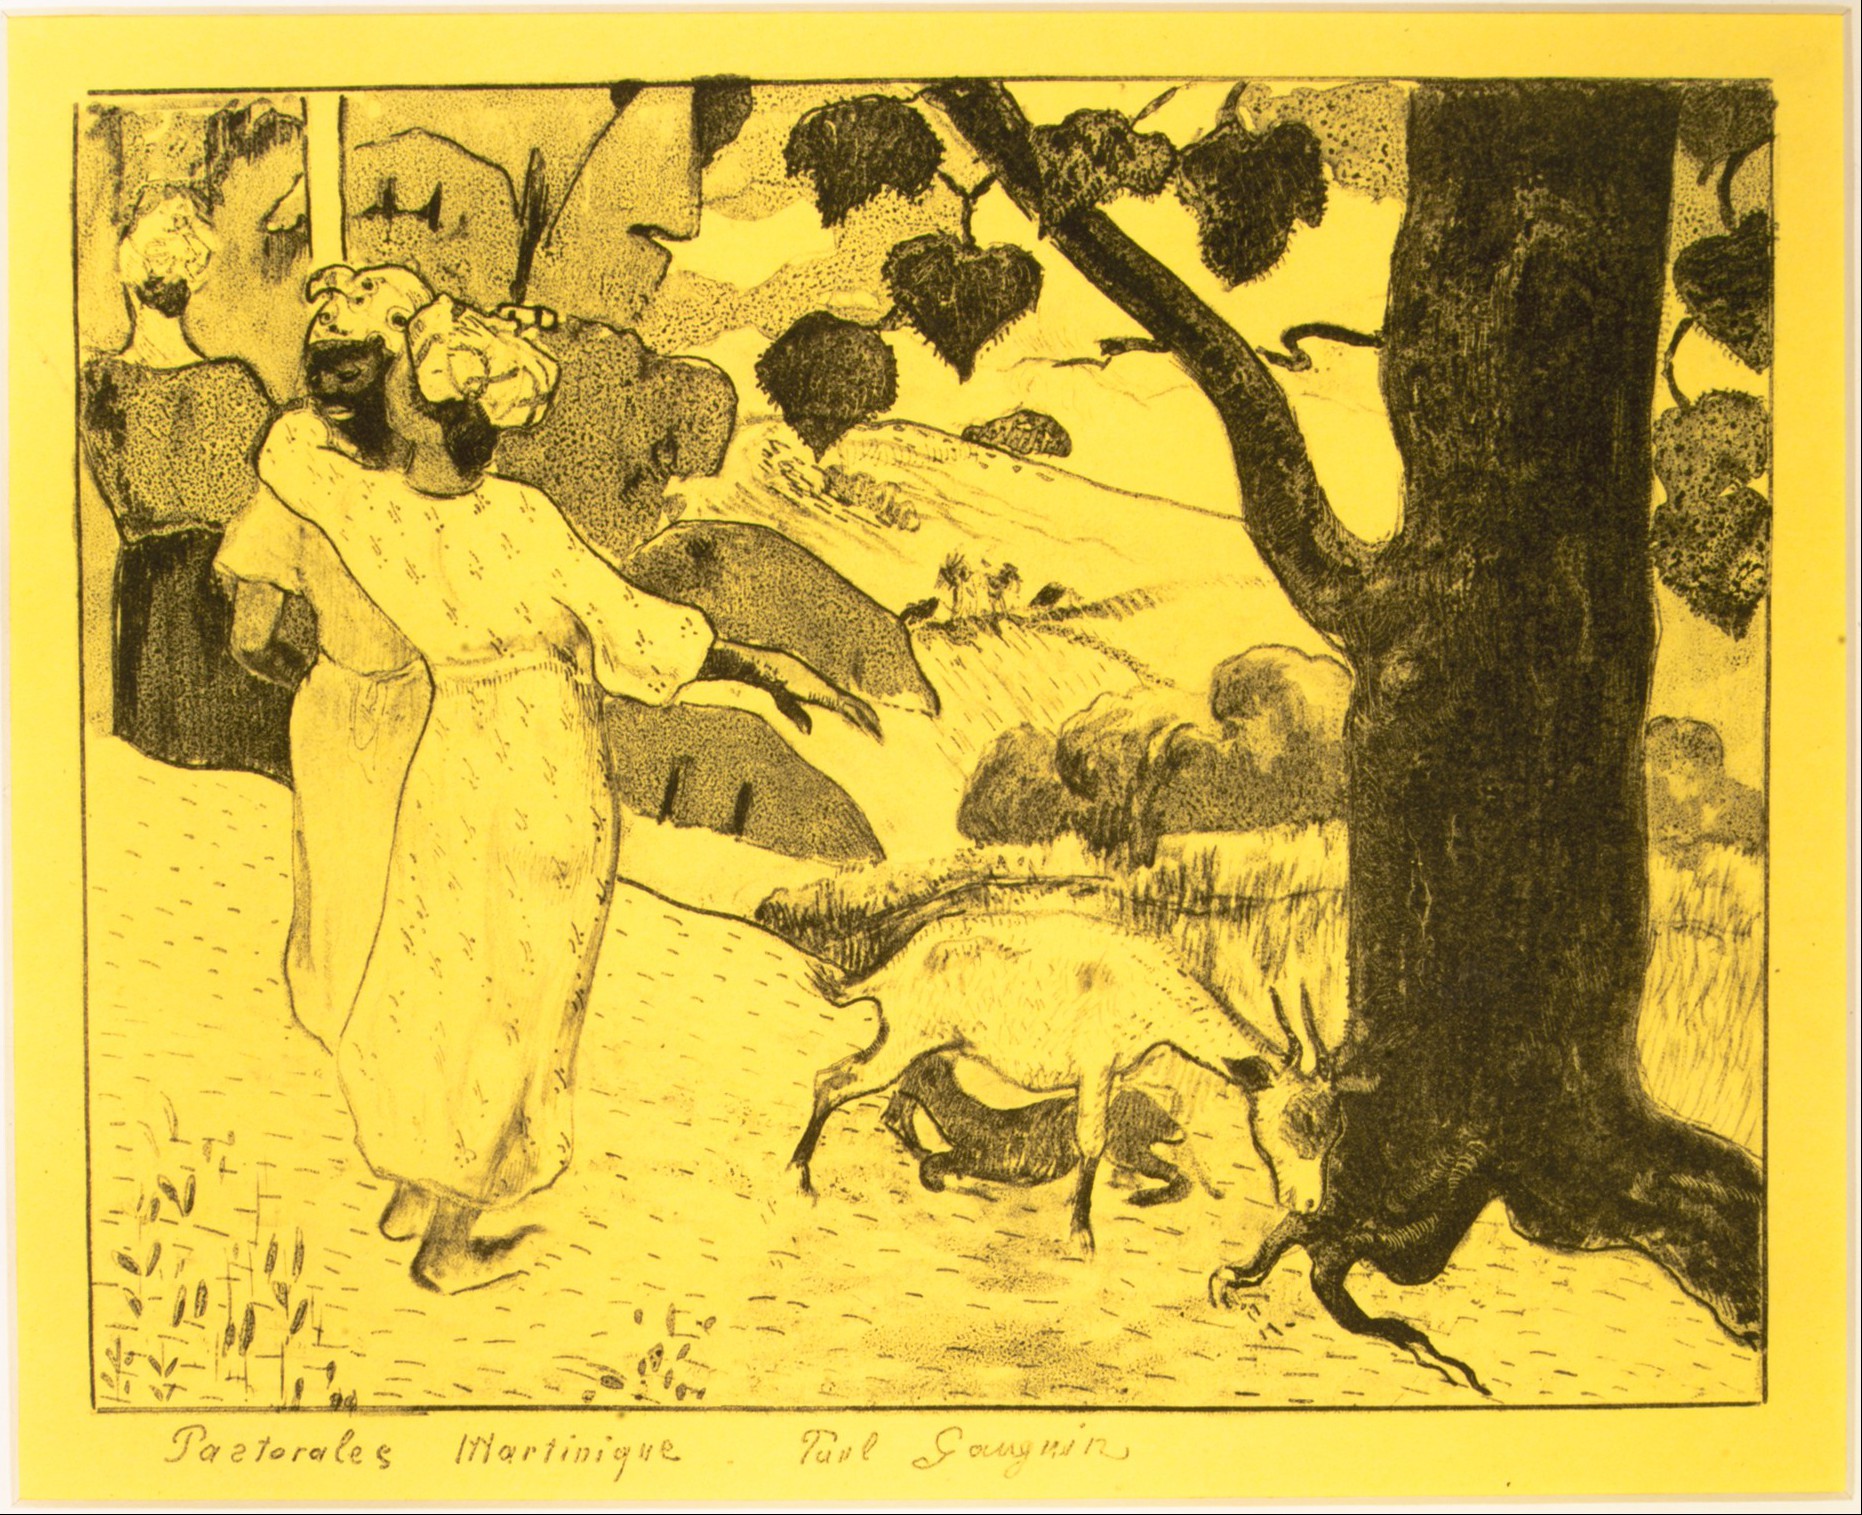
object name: print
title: Martinique Pastorals, from the "Volpini Suite: Dessins lithographiques"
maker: paul gauguin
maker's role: artist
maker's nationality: french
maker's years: 1848-1903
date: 1889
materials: paper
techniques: lithography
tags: women,goats,trees